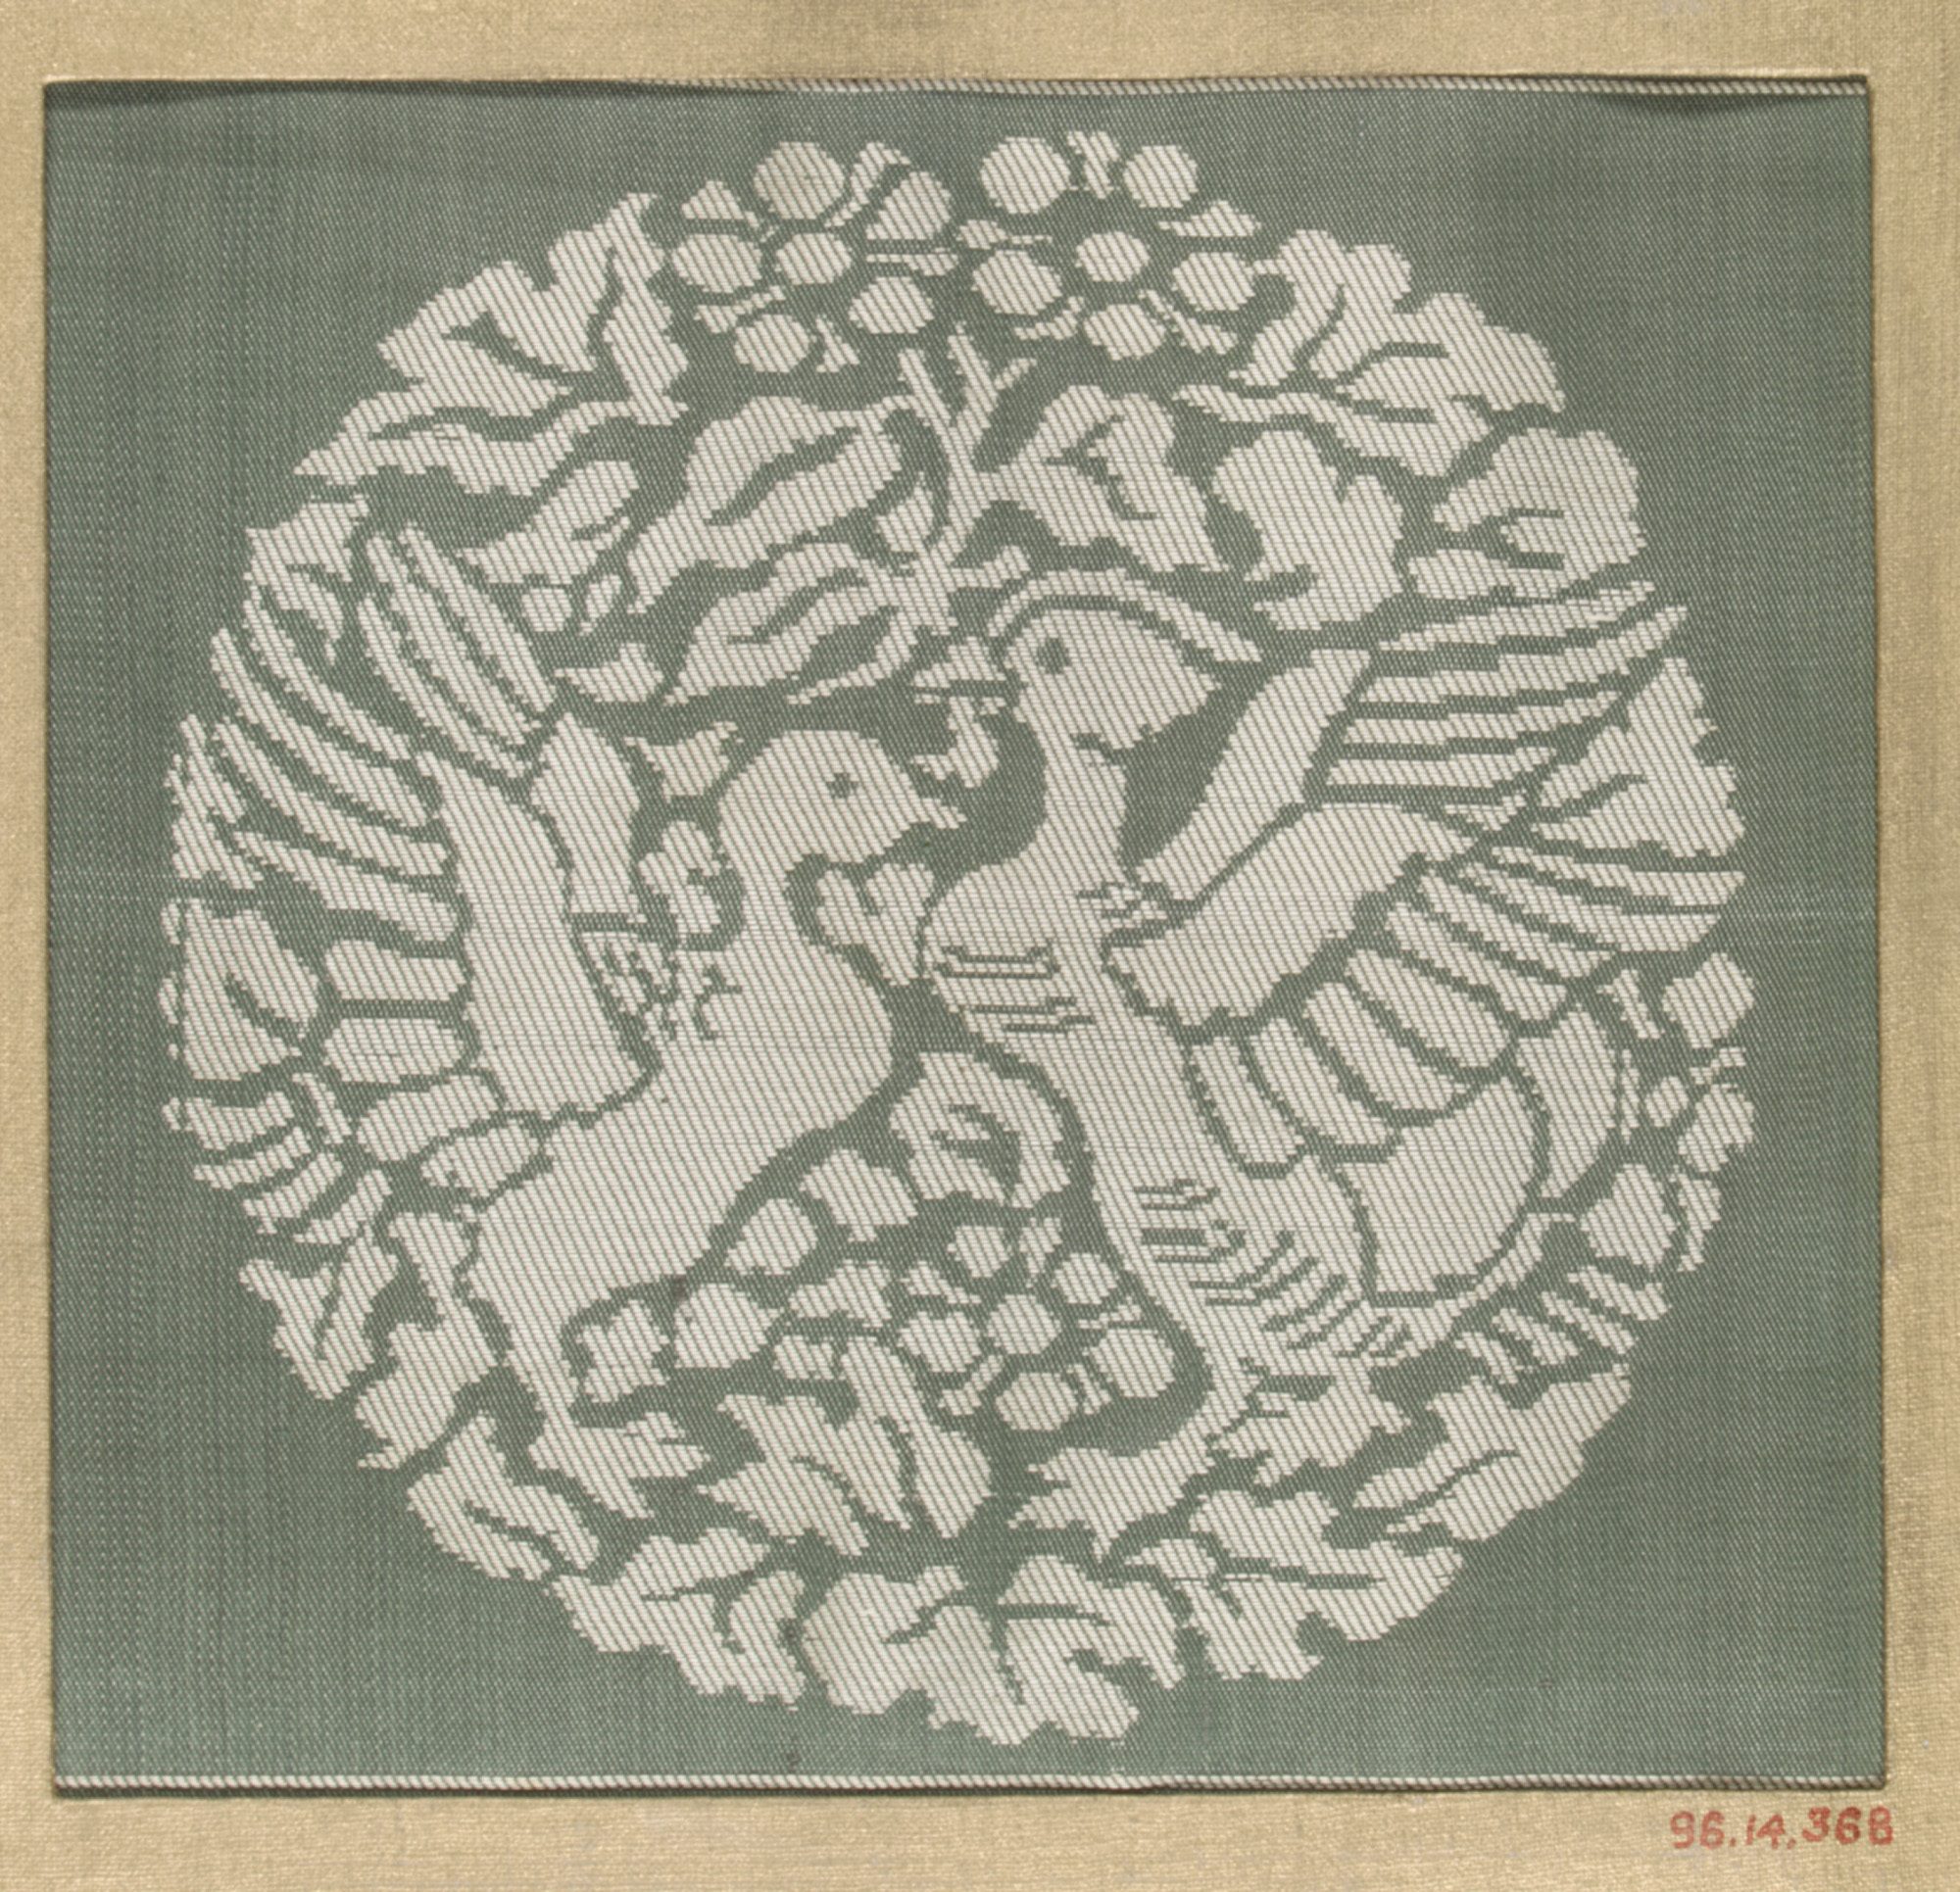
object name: piece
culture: japanese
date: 1701-1900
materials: silk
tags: ducks